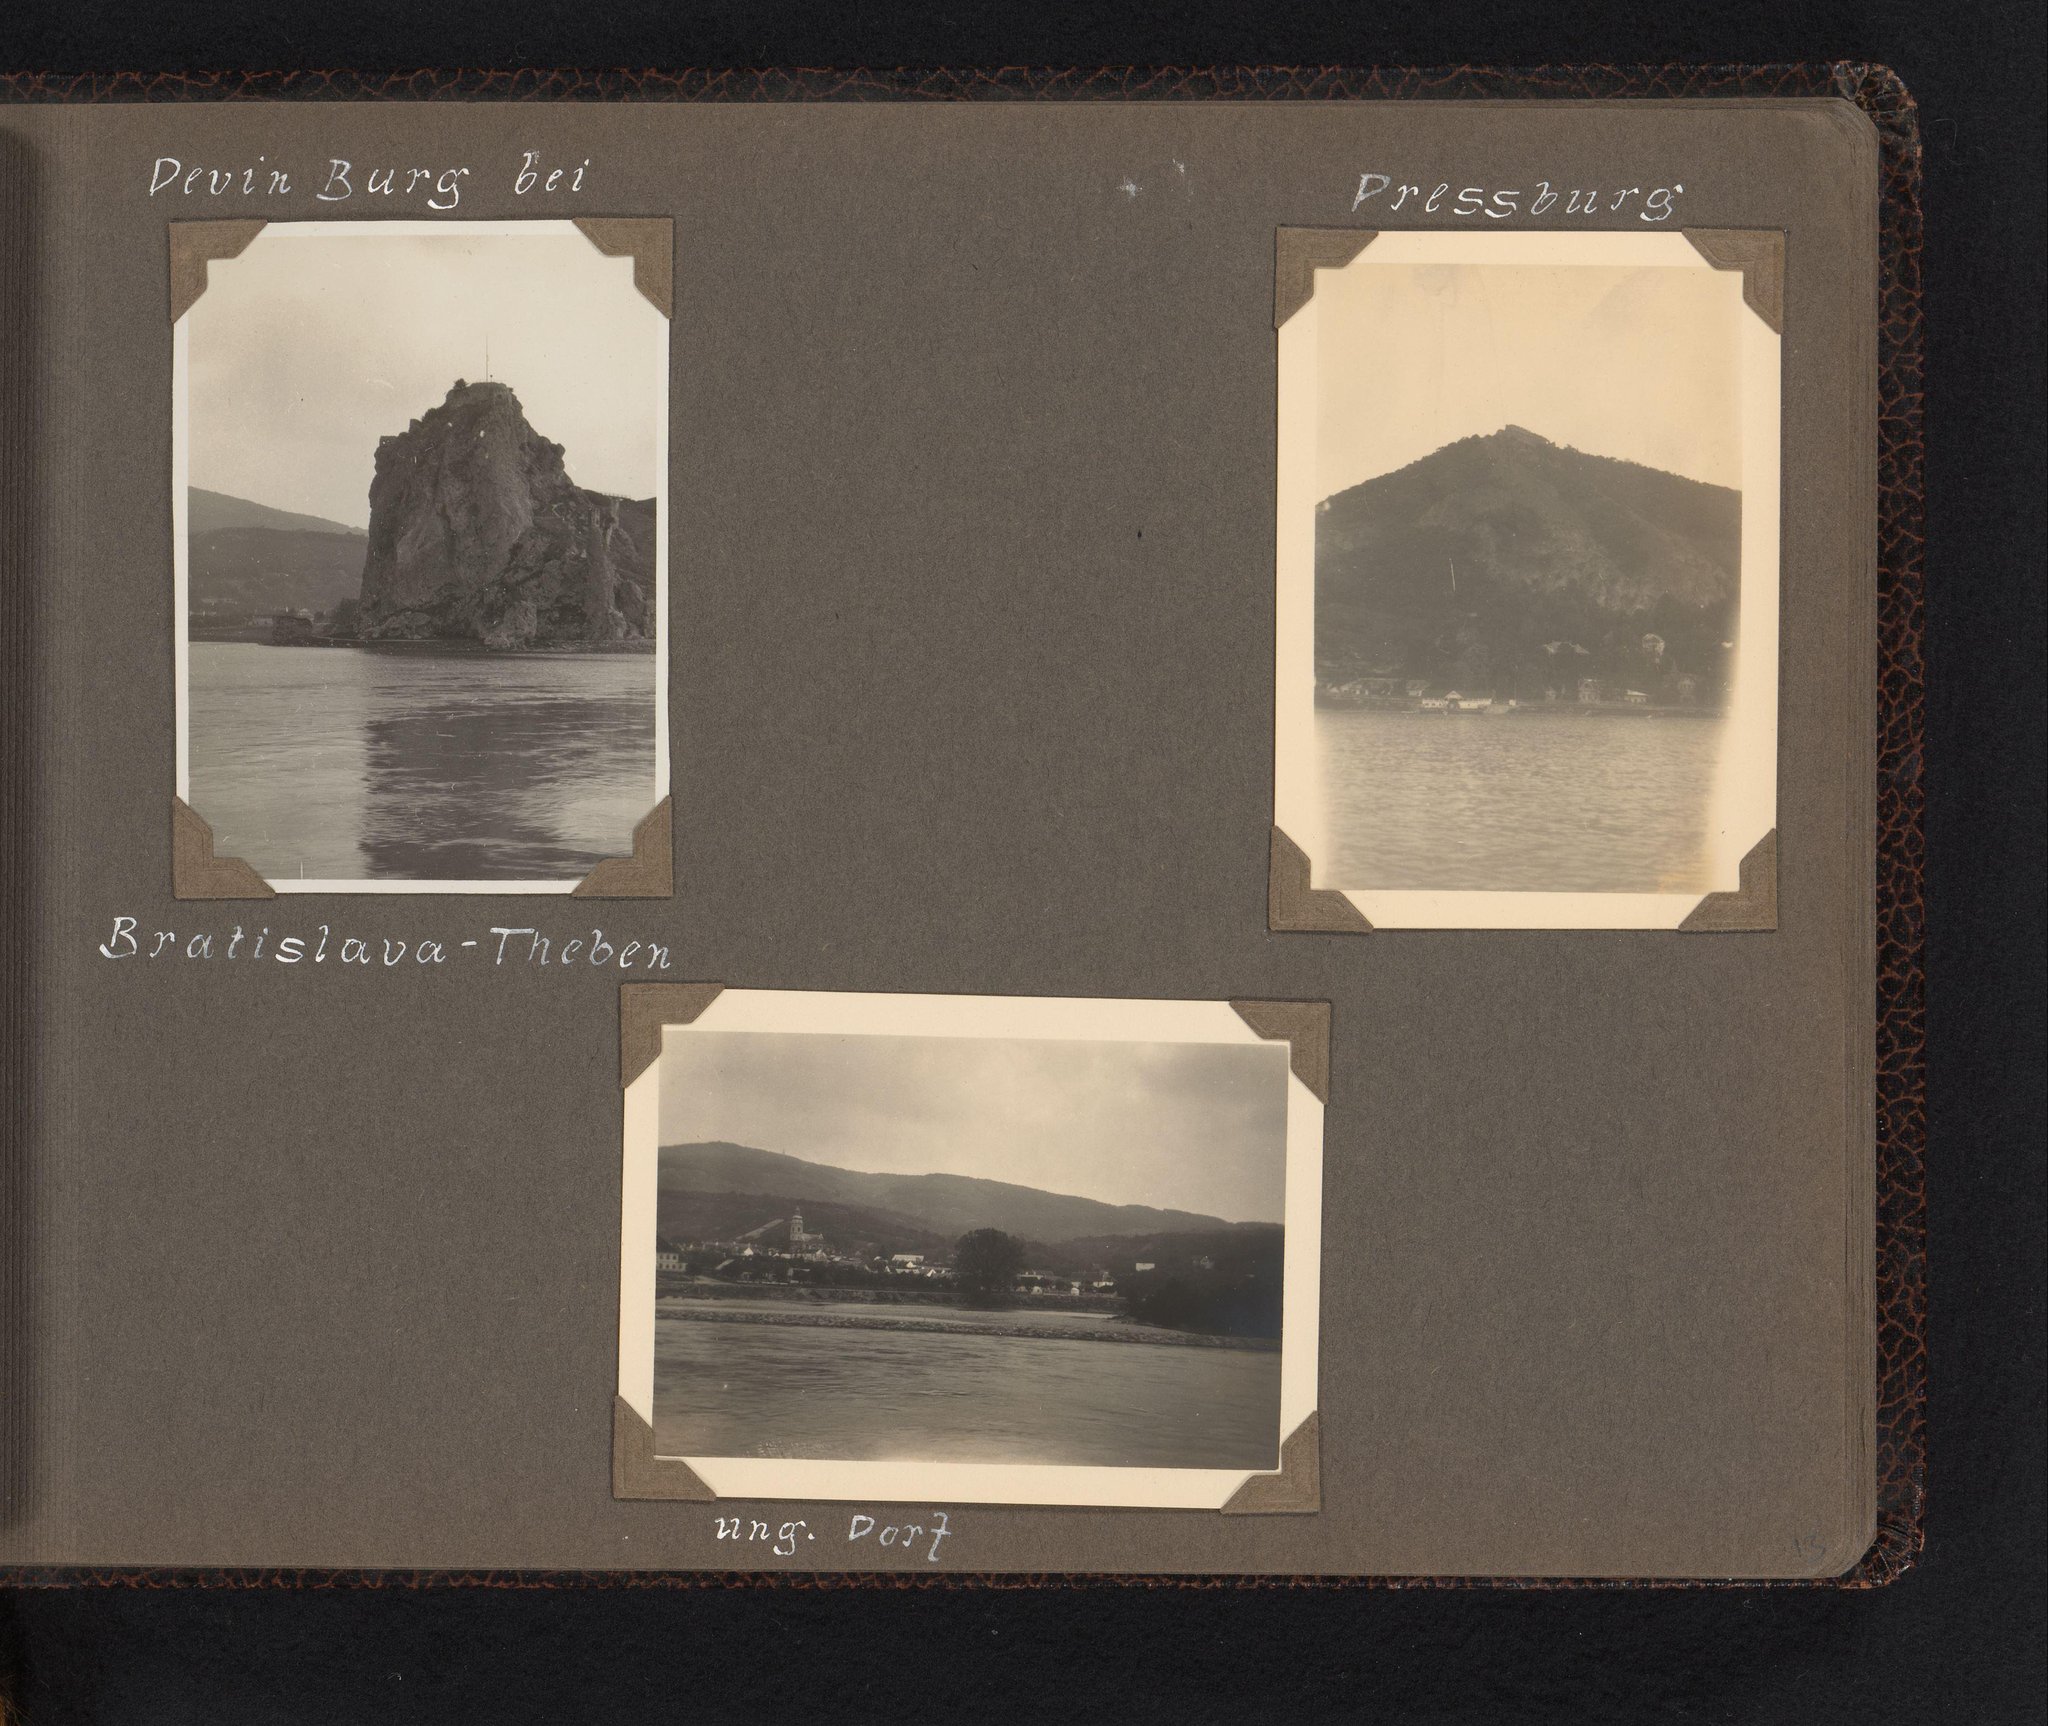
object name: photograph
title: Drie gezichten op Bratislava, het kasteel van Devín en een Hongaars dorp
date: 1930-1931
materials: cardboard, paper, photographic support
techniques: gelatin silver print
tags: city-view in general; 'veduta', river, landscape with tower or castle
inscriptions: annotation: ‘Devin Burg bei/ Bratislava-Theben/ ung. Dorf/ Pressburg’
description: Drie foto's gemaakt tijdens de boottocht over de Donau. Deze pagina maakt deel uit van een album.